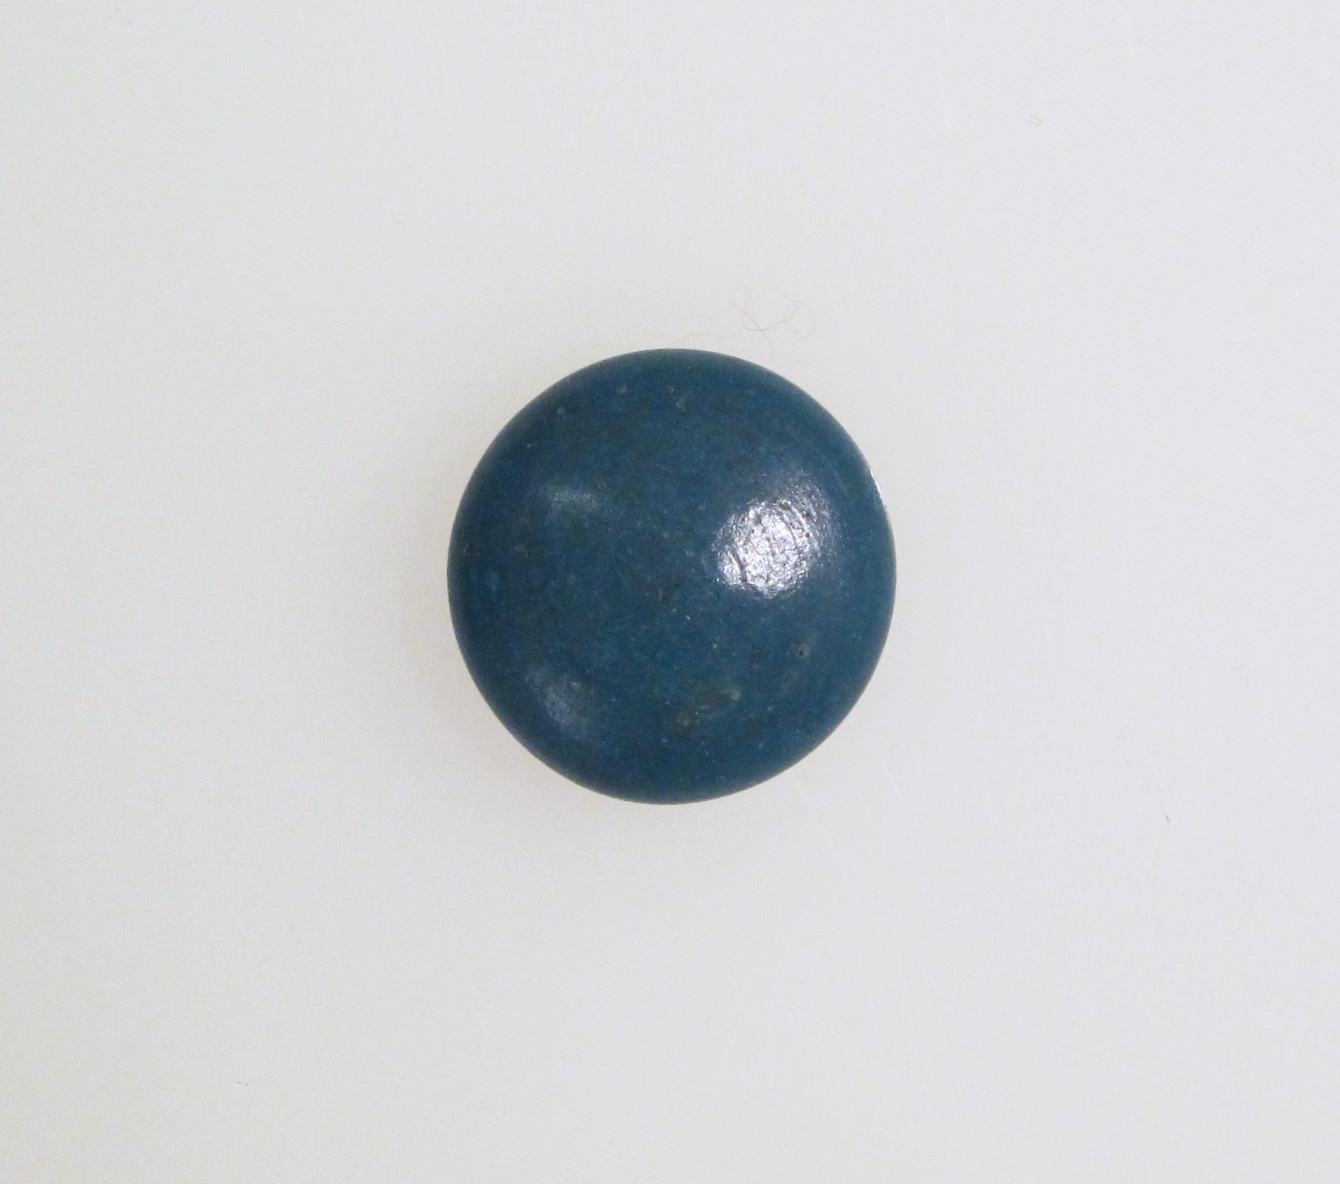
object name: pinhead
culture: roman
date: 100 BCE-500 CE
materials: glass